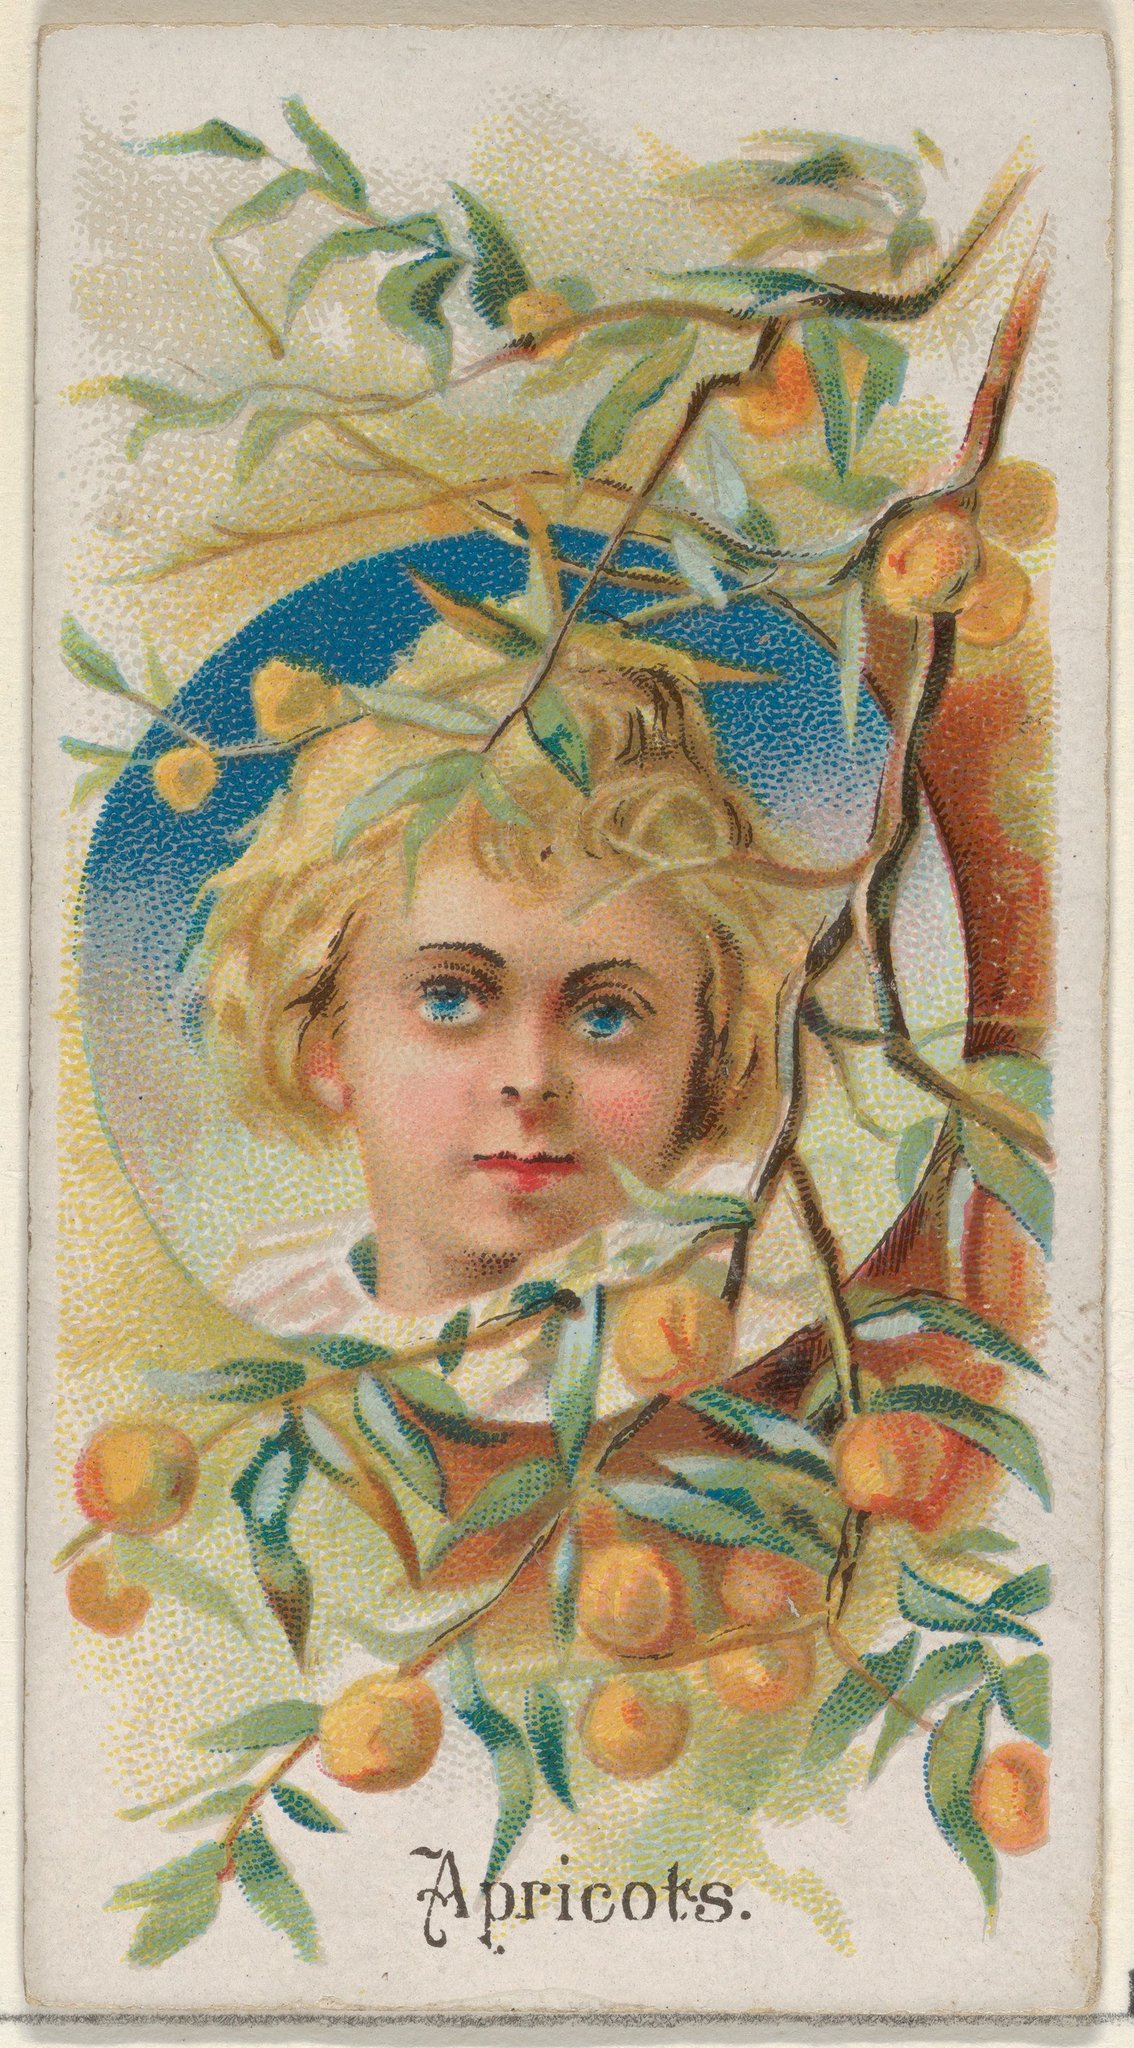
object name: print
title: Apricots, from the Fruits series (N12) for Allen & Ginter Cigarettes Brands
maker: allen & ginter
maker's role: publisher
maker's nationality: american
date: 1891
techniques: color lithograph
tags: fruit,girls